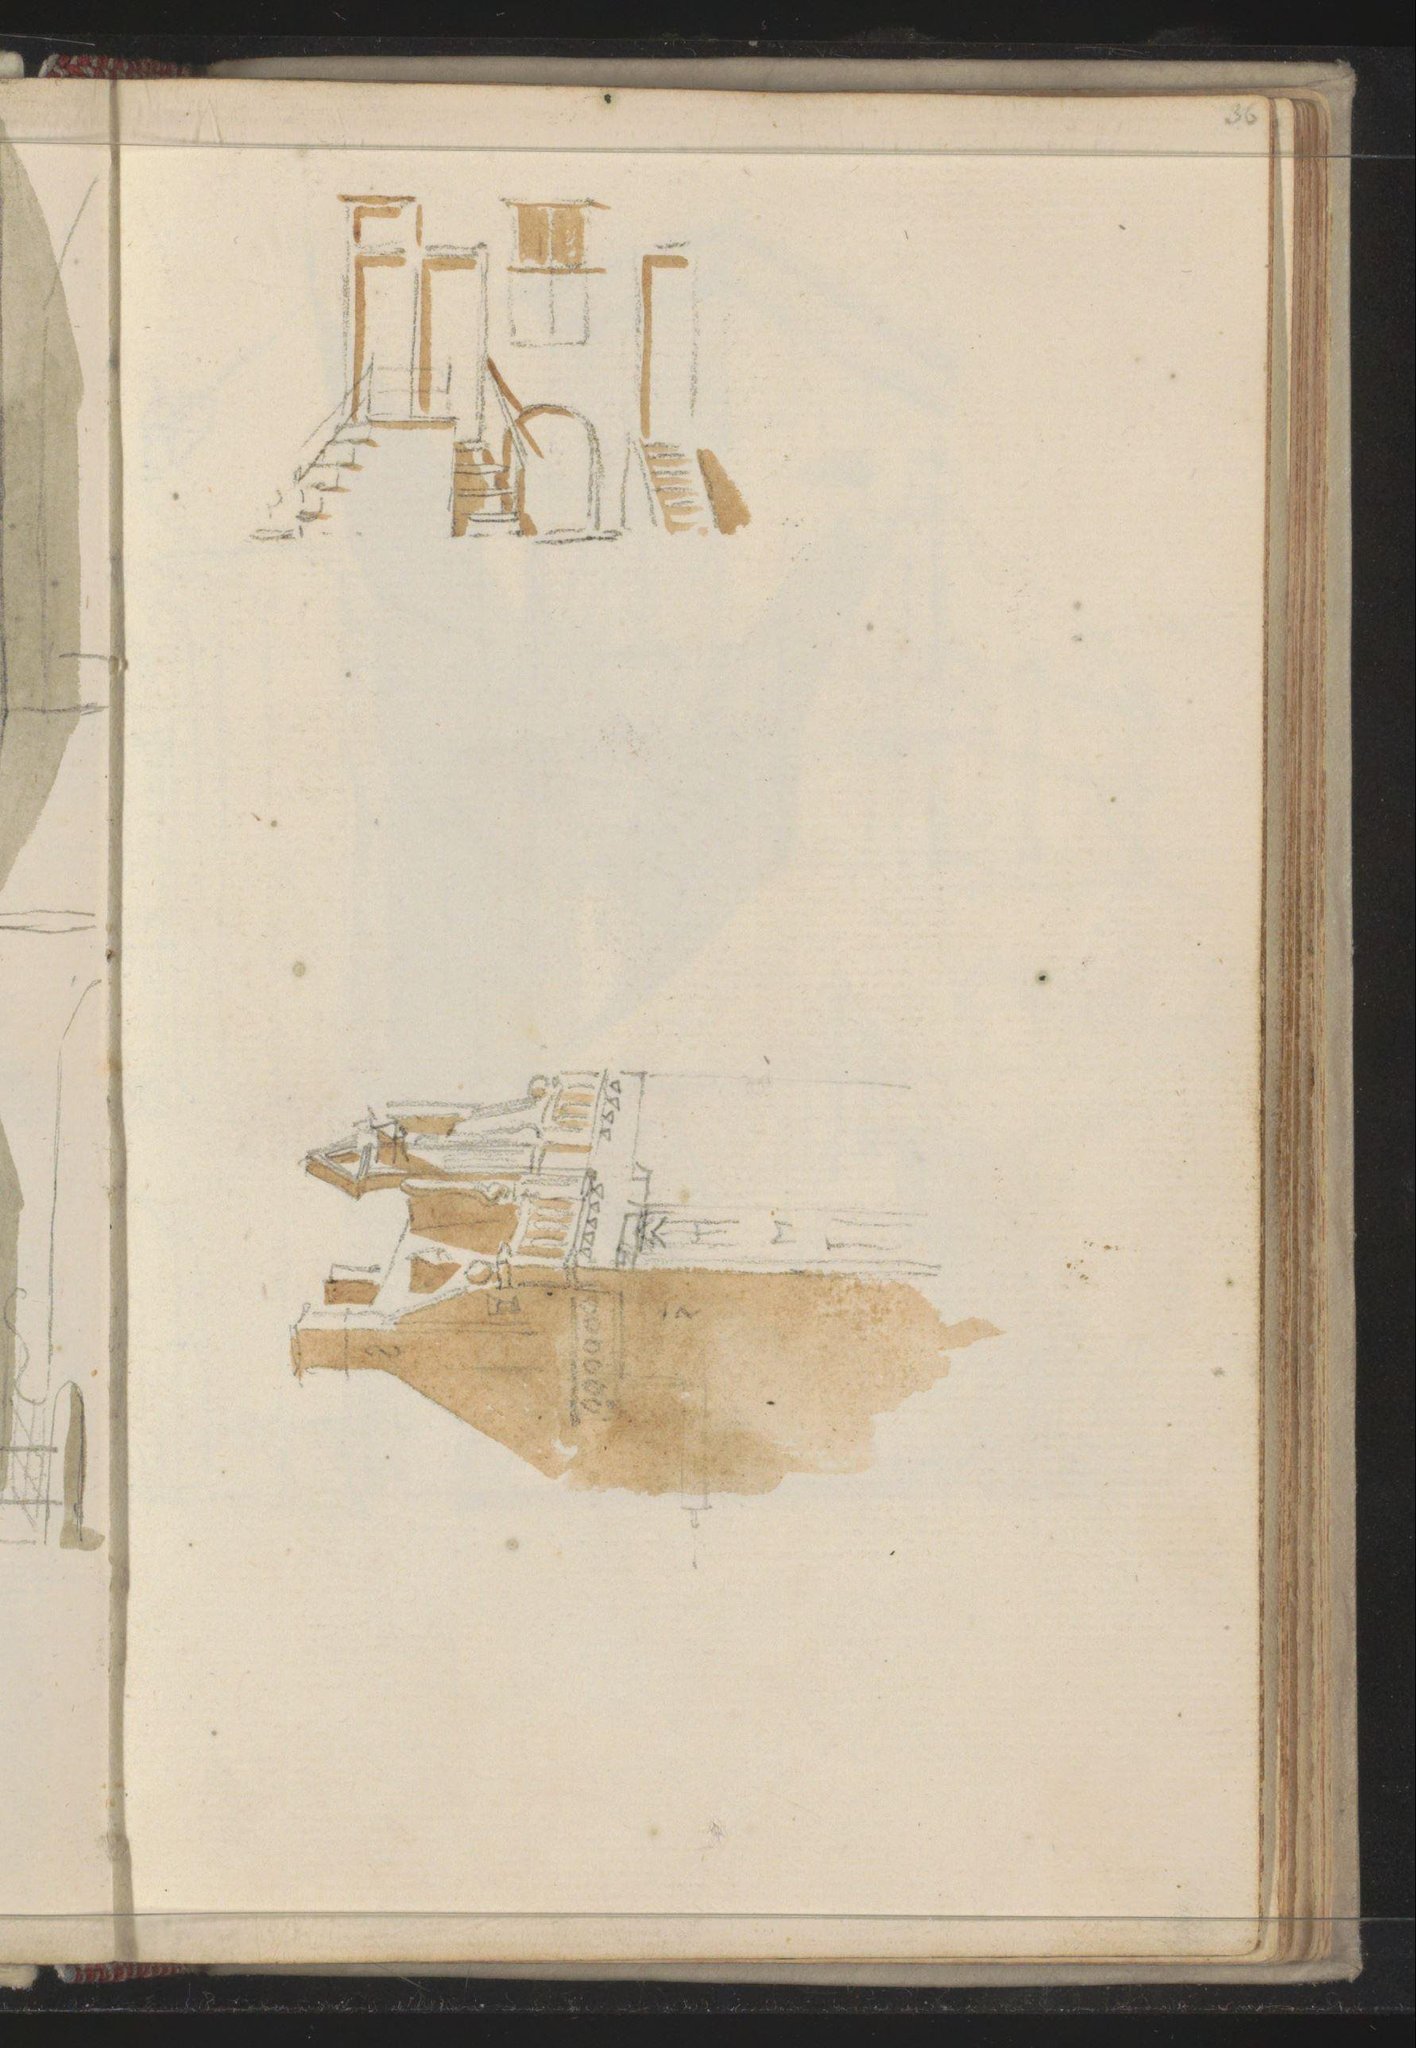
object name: sketchbook leaf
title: Architectuur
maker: johannes huibert prins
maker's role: draughtsman, painter, print maker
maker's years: 1757-1806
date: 1783-1797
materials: paper, pencil, watercolor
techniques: brush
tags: decorated gable, front steps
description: Studie van een trap voor een voordeur en van een gevel met rolwerk. Pagina 36 uit een schetsboek met 175 pagina's.